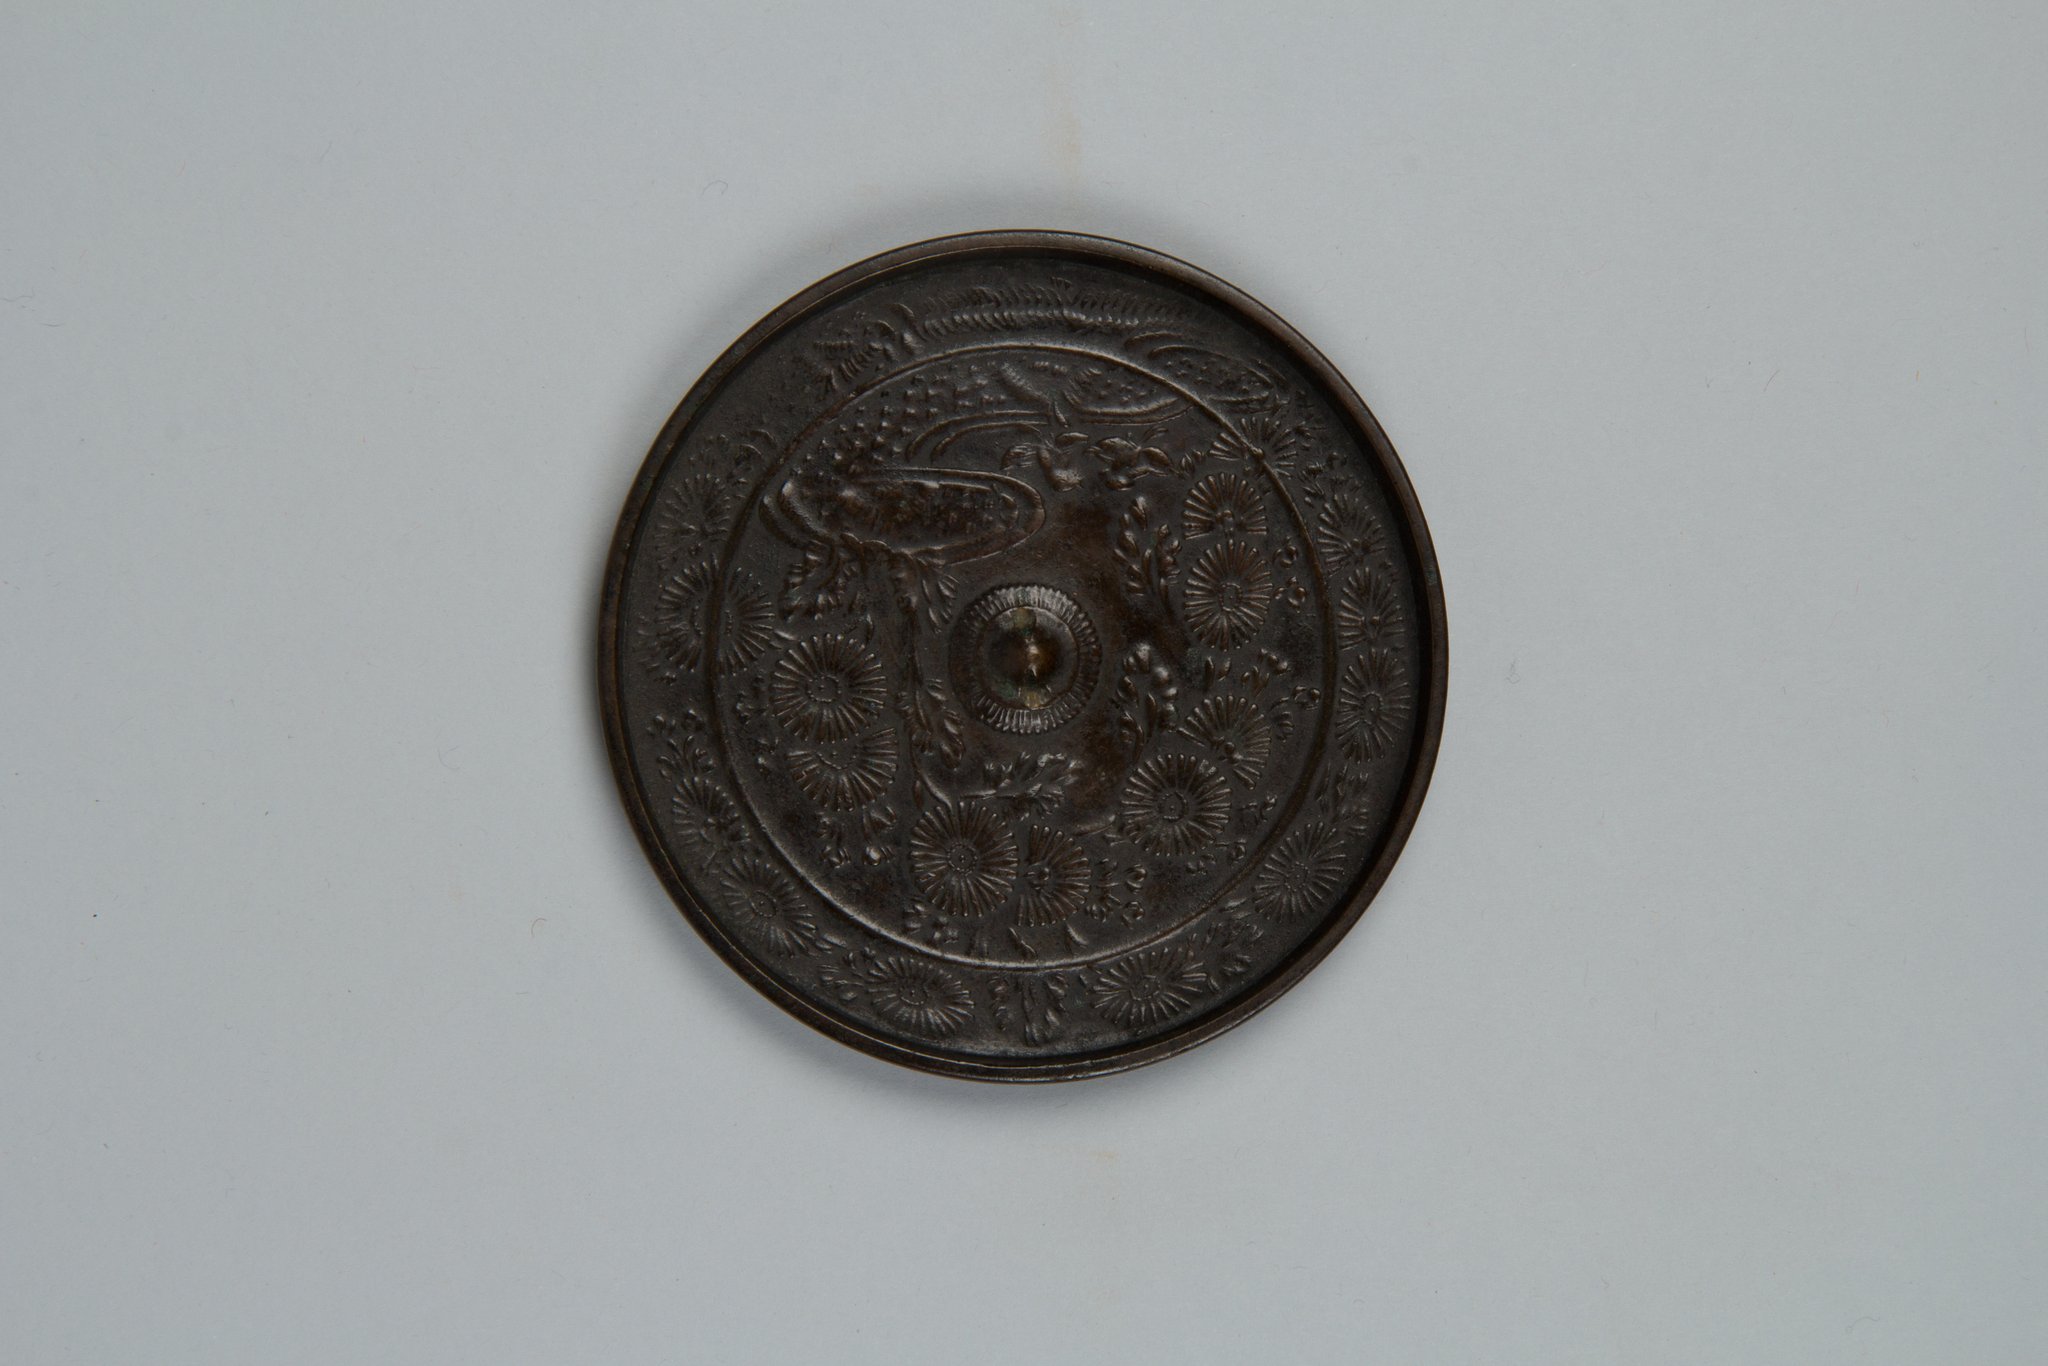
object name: mirror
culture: japanese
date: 1185-1333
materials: bronze